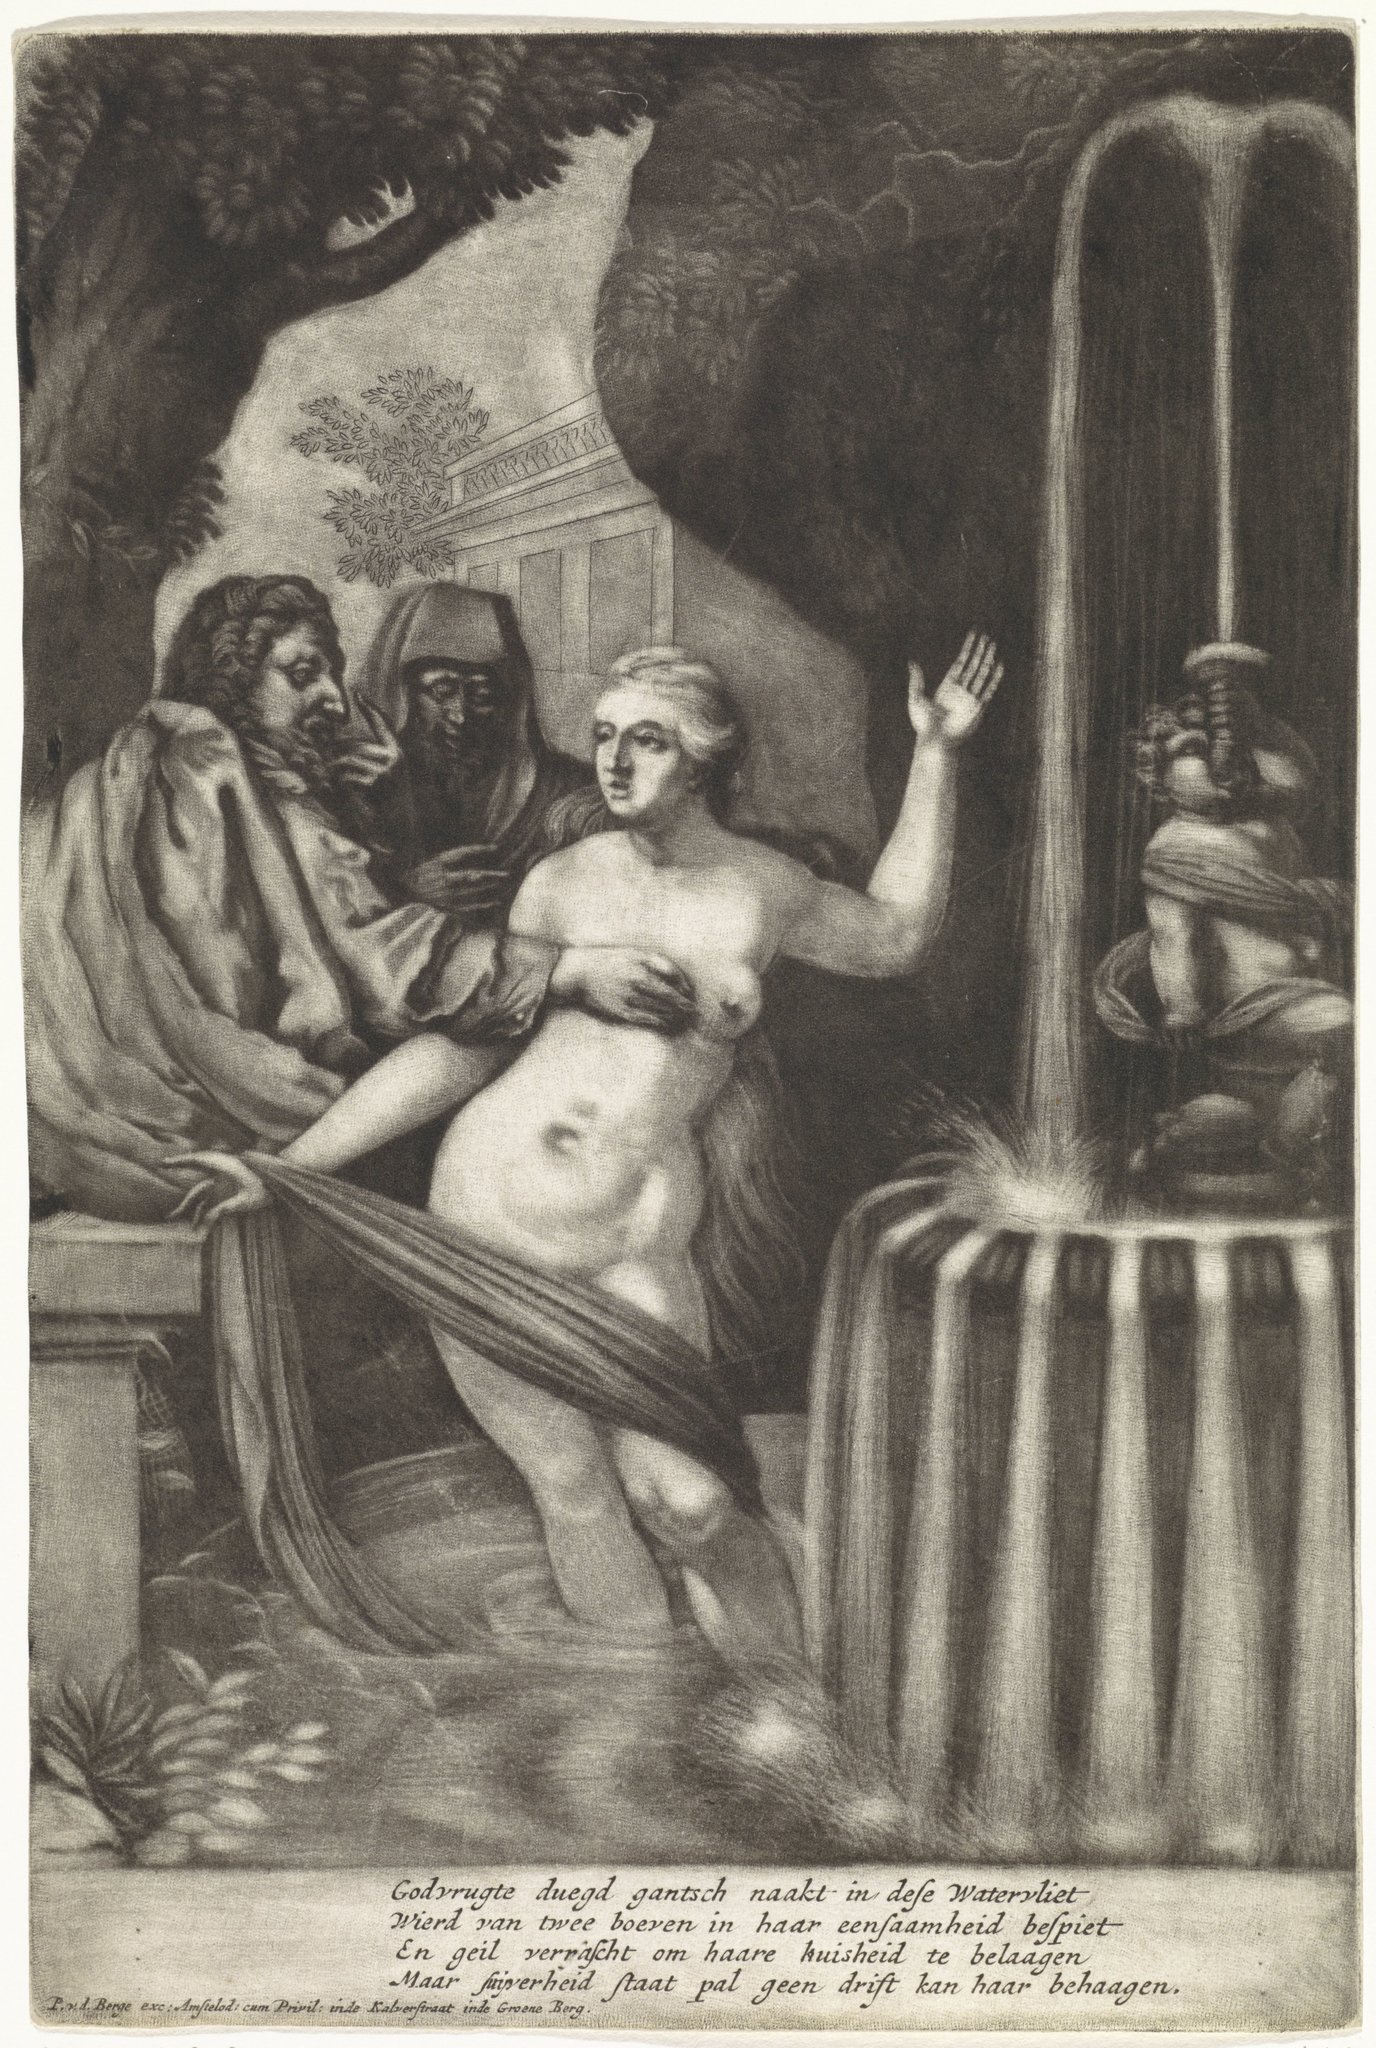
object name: print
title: Suzanna en de ouderlingen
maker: pieter van den berge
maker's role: draughtsman, print maker, printer, publisher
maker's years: 1659-1737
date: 1692-1737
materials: paper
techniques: engraving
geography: amsterdam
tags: garden fountain, the story of susanna and the elders (in which the youth daniel intervenes on behalf of susanna) (daniel 13)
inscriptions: collector's mark: Lugt 2228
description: Suzanna wordt tijdens haar bad overvallen door twee ouderlingen. Zij staat in een fontein terwijl een van de mannen haar betast en een gebaar maakt om haar tot zwijgen te brengen. In de marge vier regels met een verklaring van het tafereel.